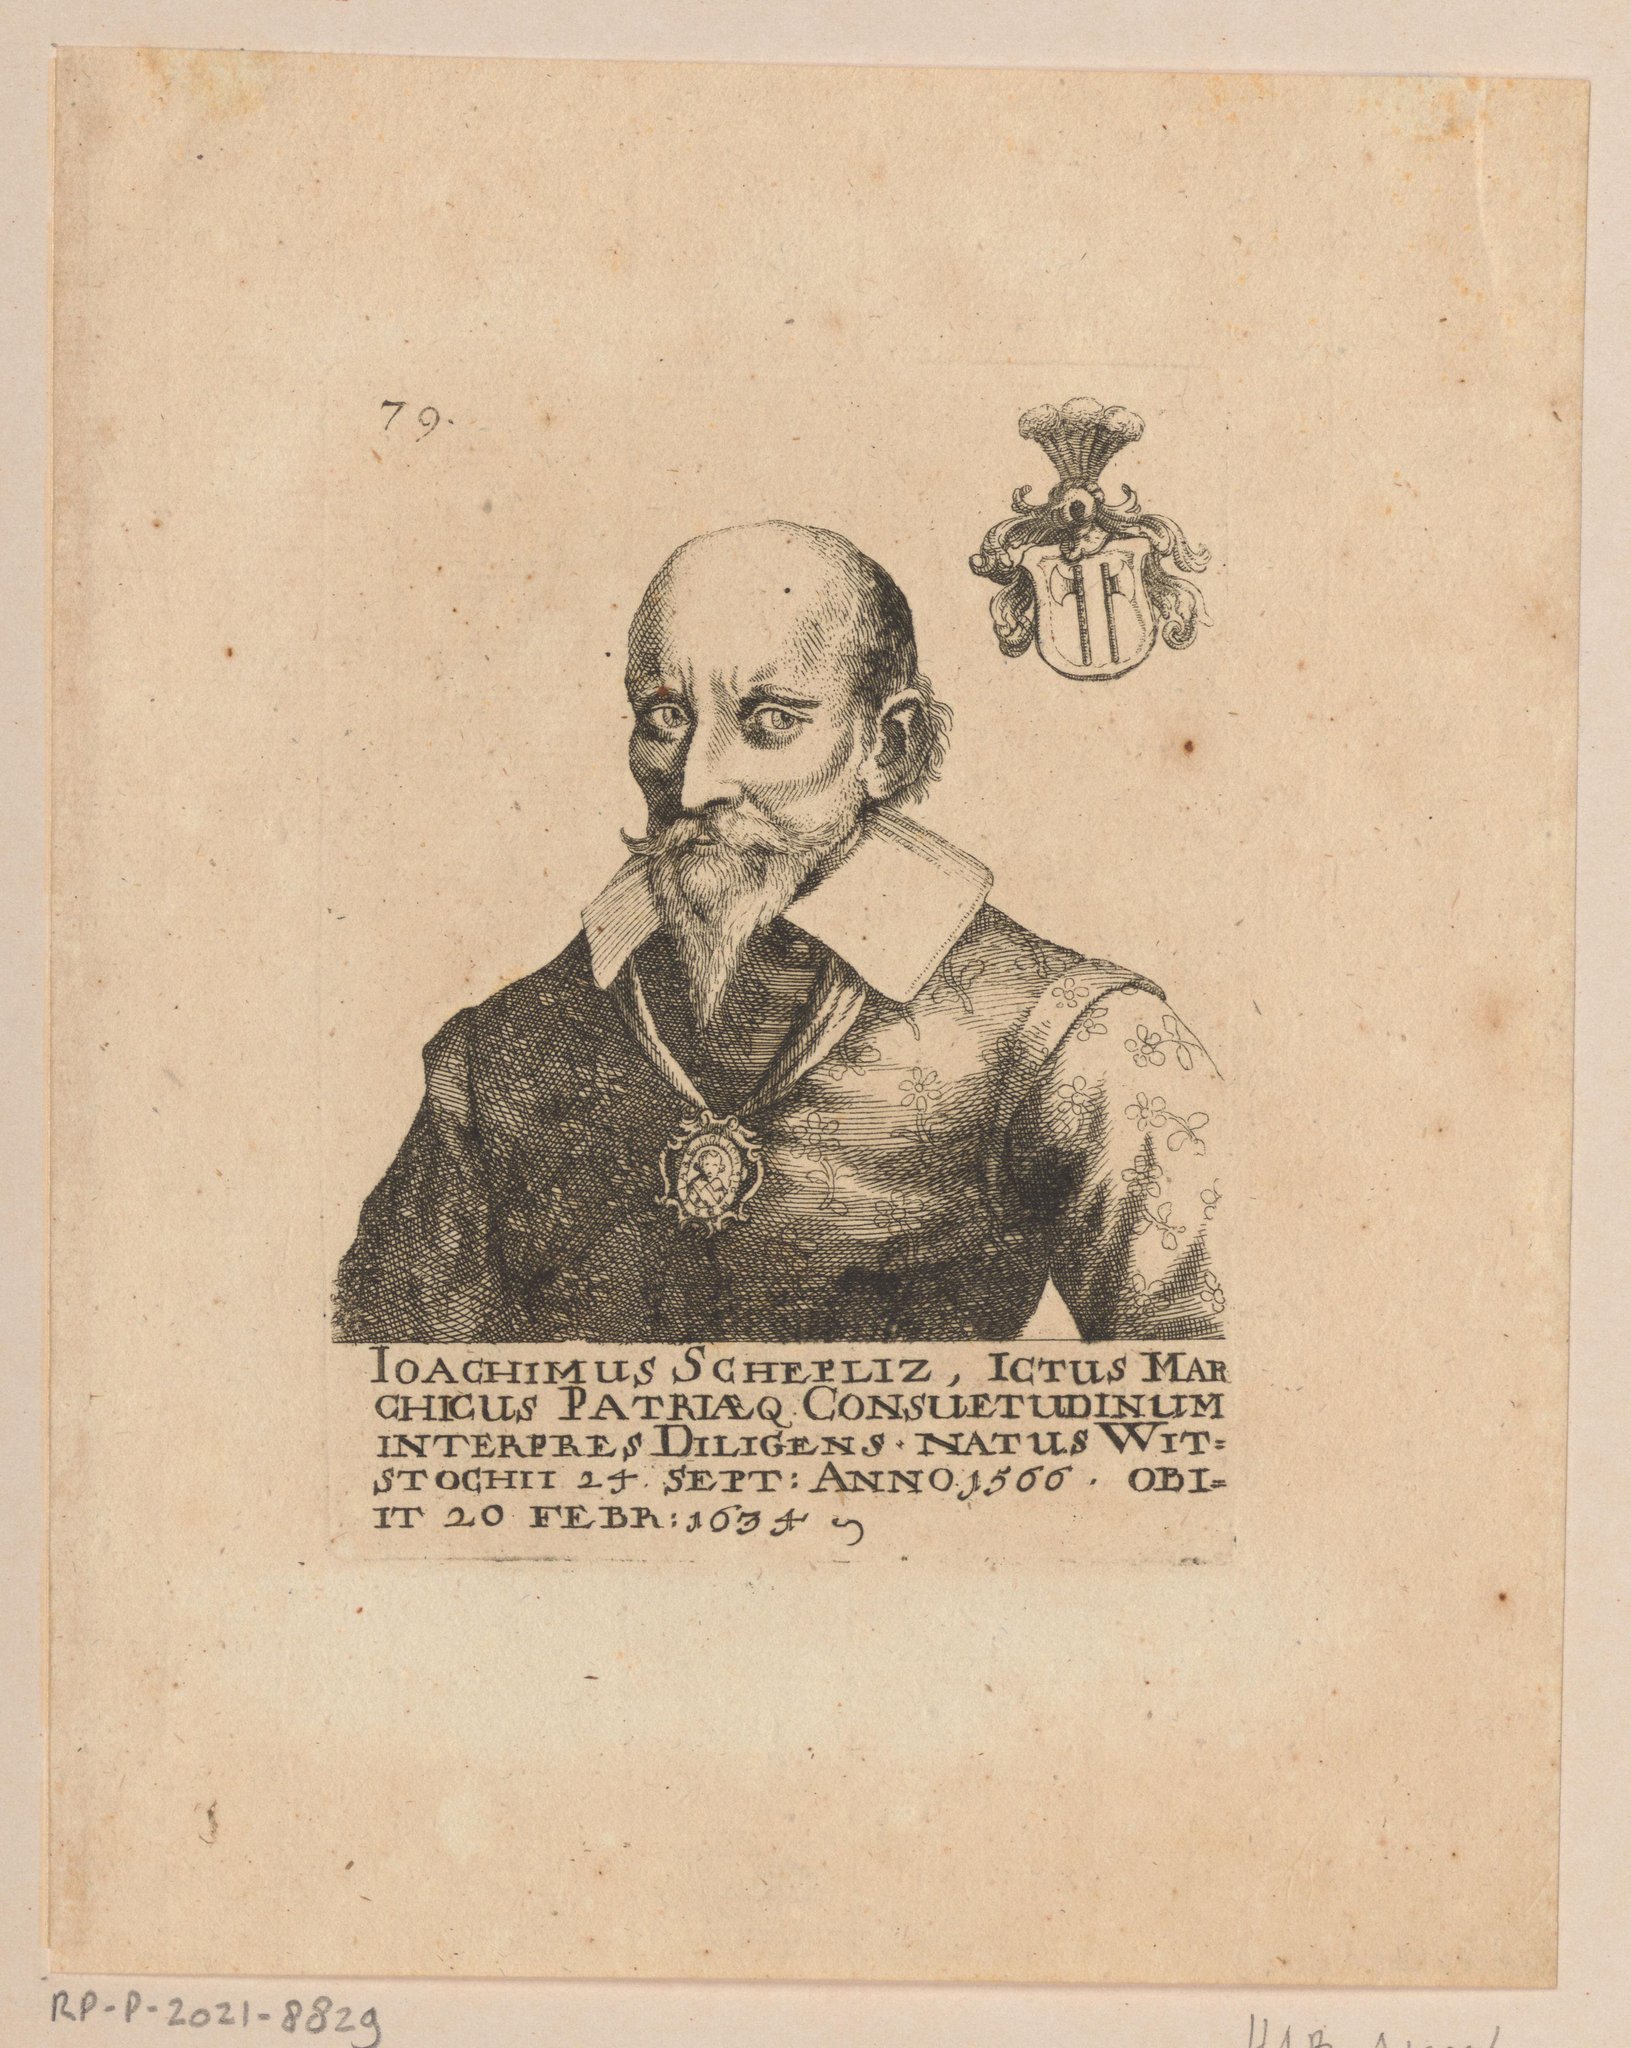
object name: print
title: Illustere mannen verzameld door Martin Friedrich Seidel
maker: Anonymous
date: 1671-1751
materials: paper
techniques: etching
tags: historical persons, law and jurisprudence, armorial bearing, heraldry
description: De prent is uitgegeven als onderdeel van een serie. Later is de prent mogelijk ook als boekillustratie gebruikt in: Küster, Georg Gottfried. Martin Friedrich Seidels Bilder-Sammlung in welcher hundert, gröstentheils in der Mark Brandenburg (…). Berlijn: Buchladen bey der Real-Schule, 1751. Het is onduidelijk tot welke uitgave de huidige prent behoort.